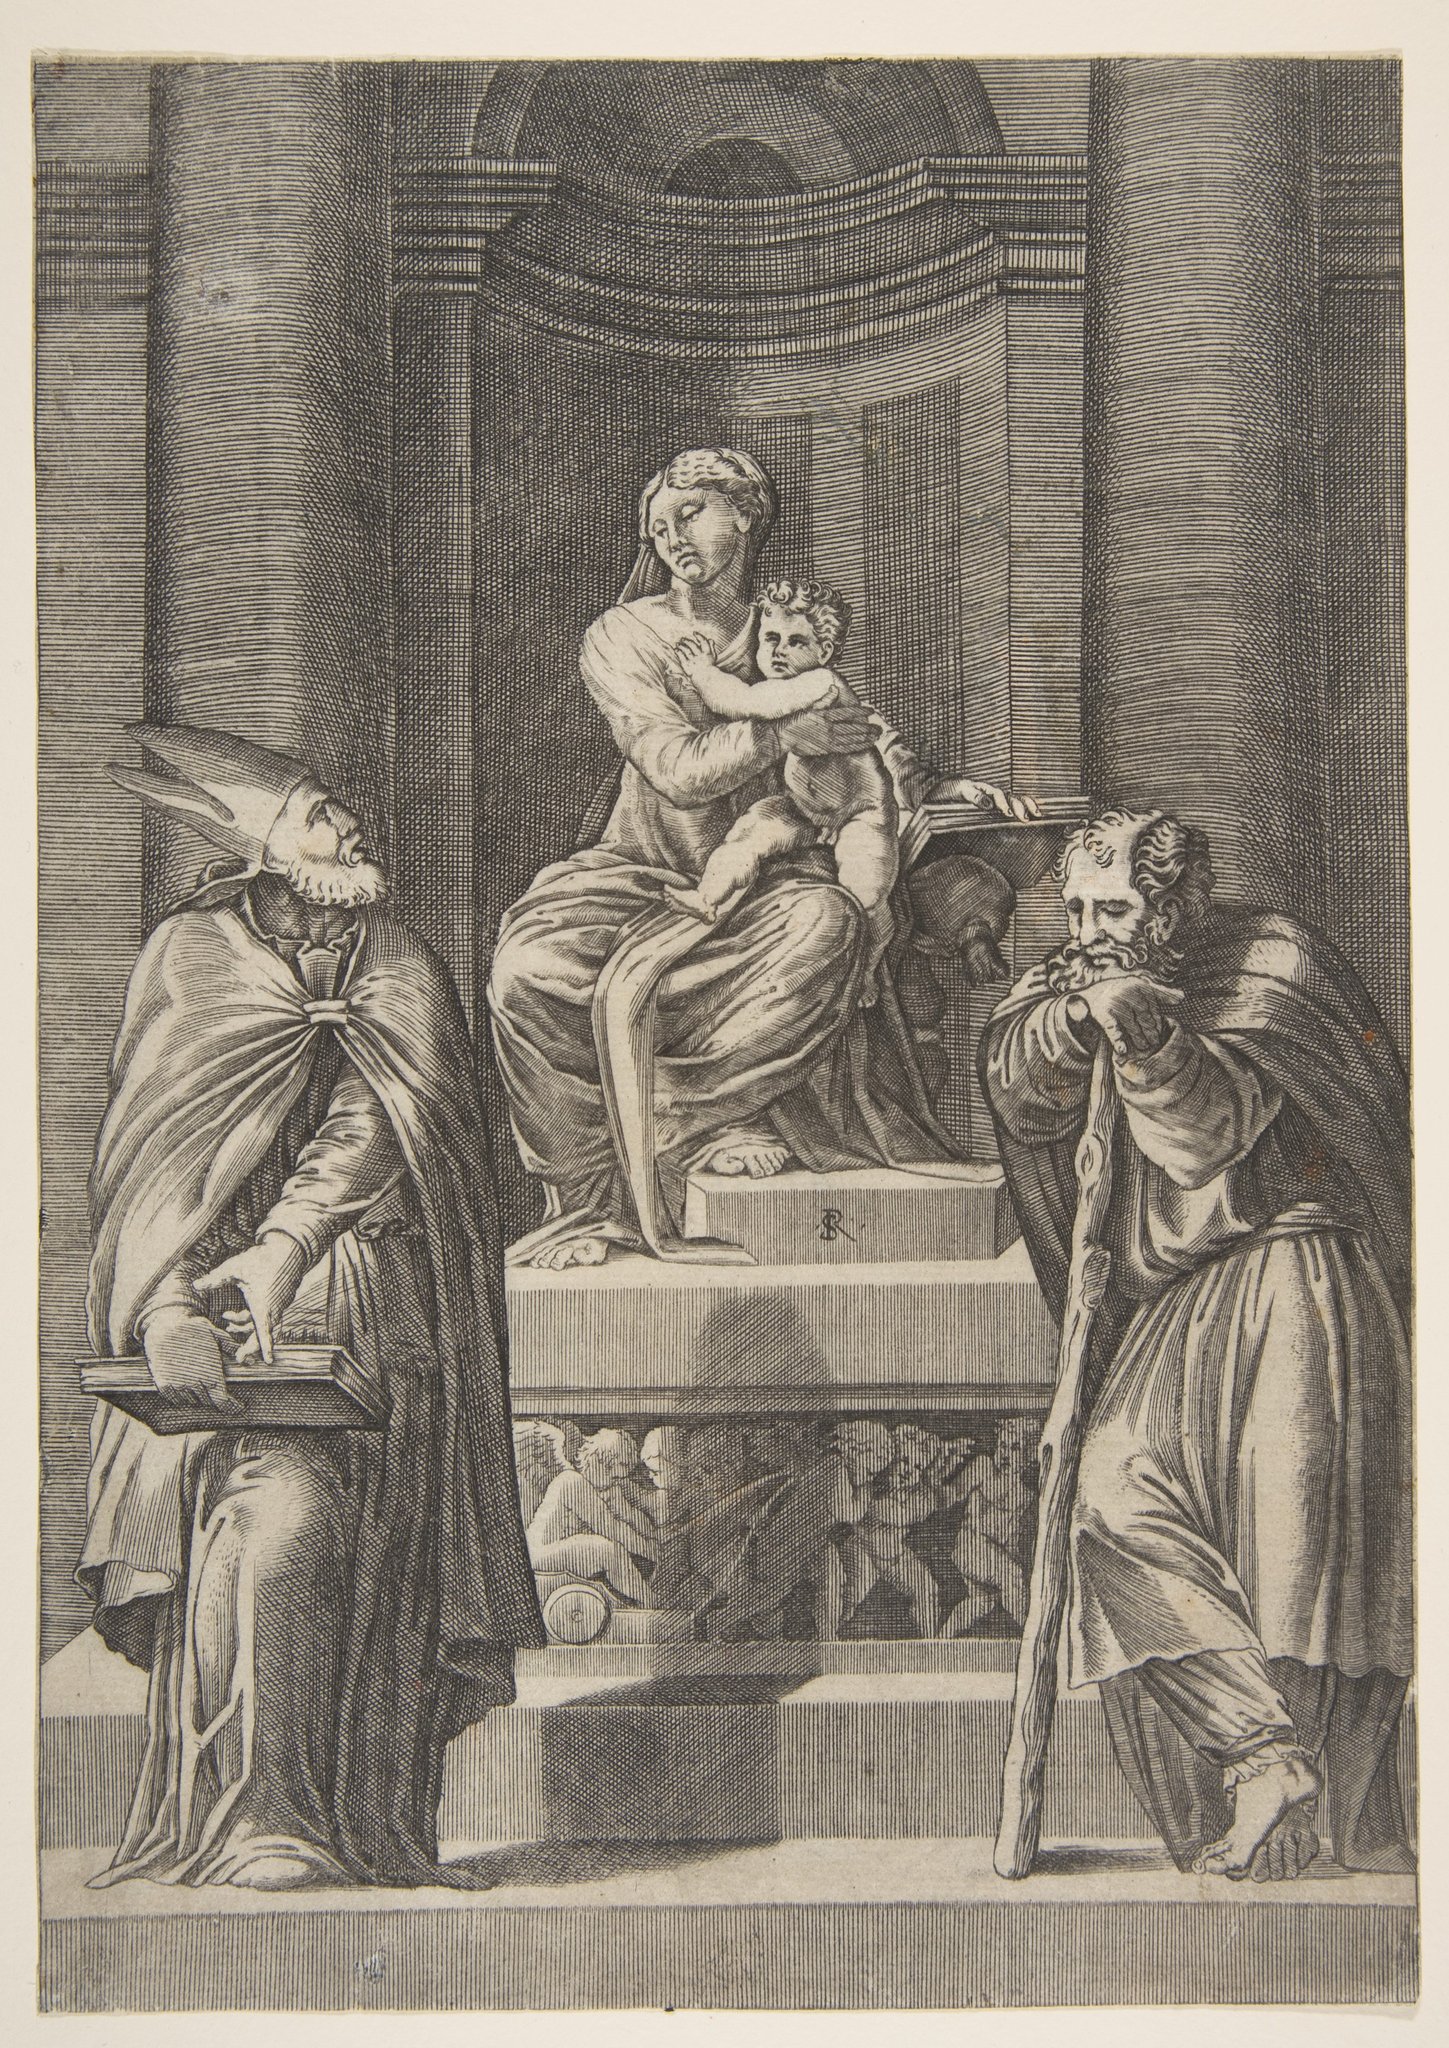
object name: print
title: Saint Joseph at left and a bishop at right standing before the altar of the Virgin and Christ Child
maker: marco dente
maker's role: artist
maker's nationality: italian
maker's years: 1515-1527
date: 1515-1527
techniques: engraving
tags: altars,men,madonna and child,saint joseph